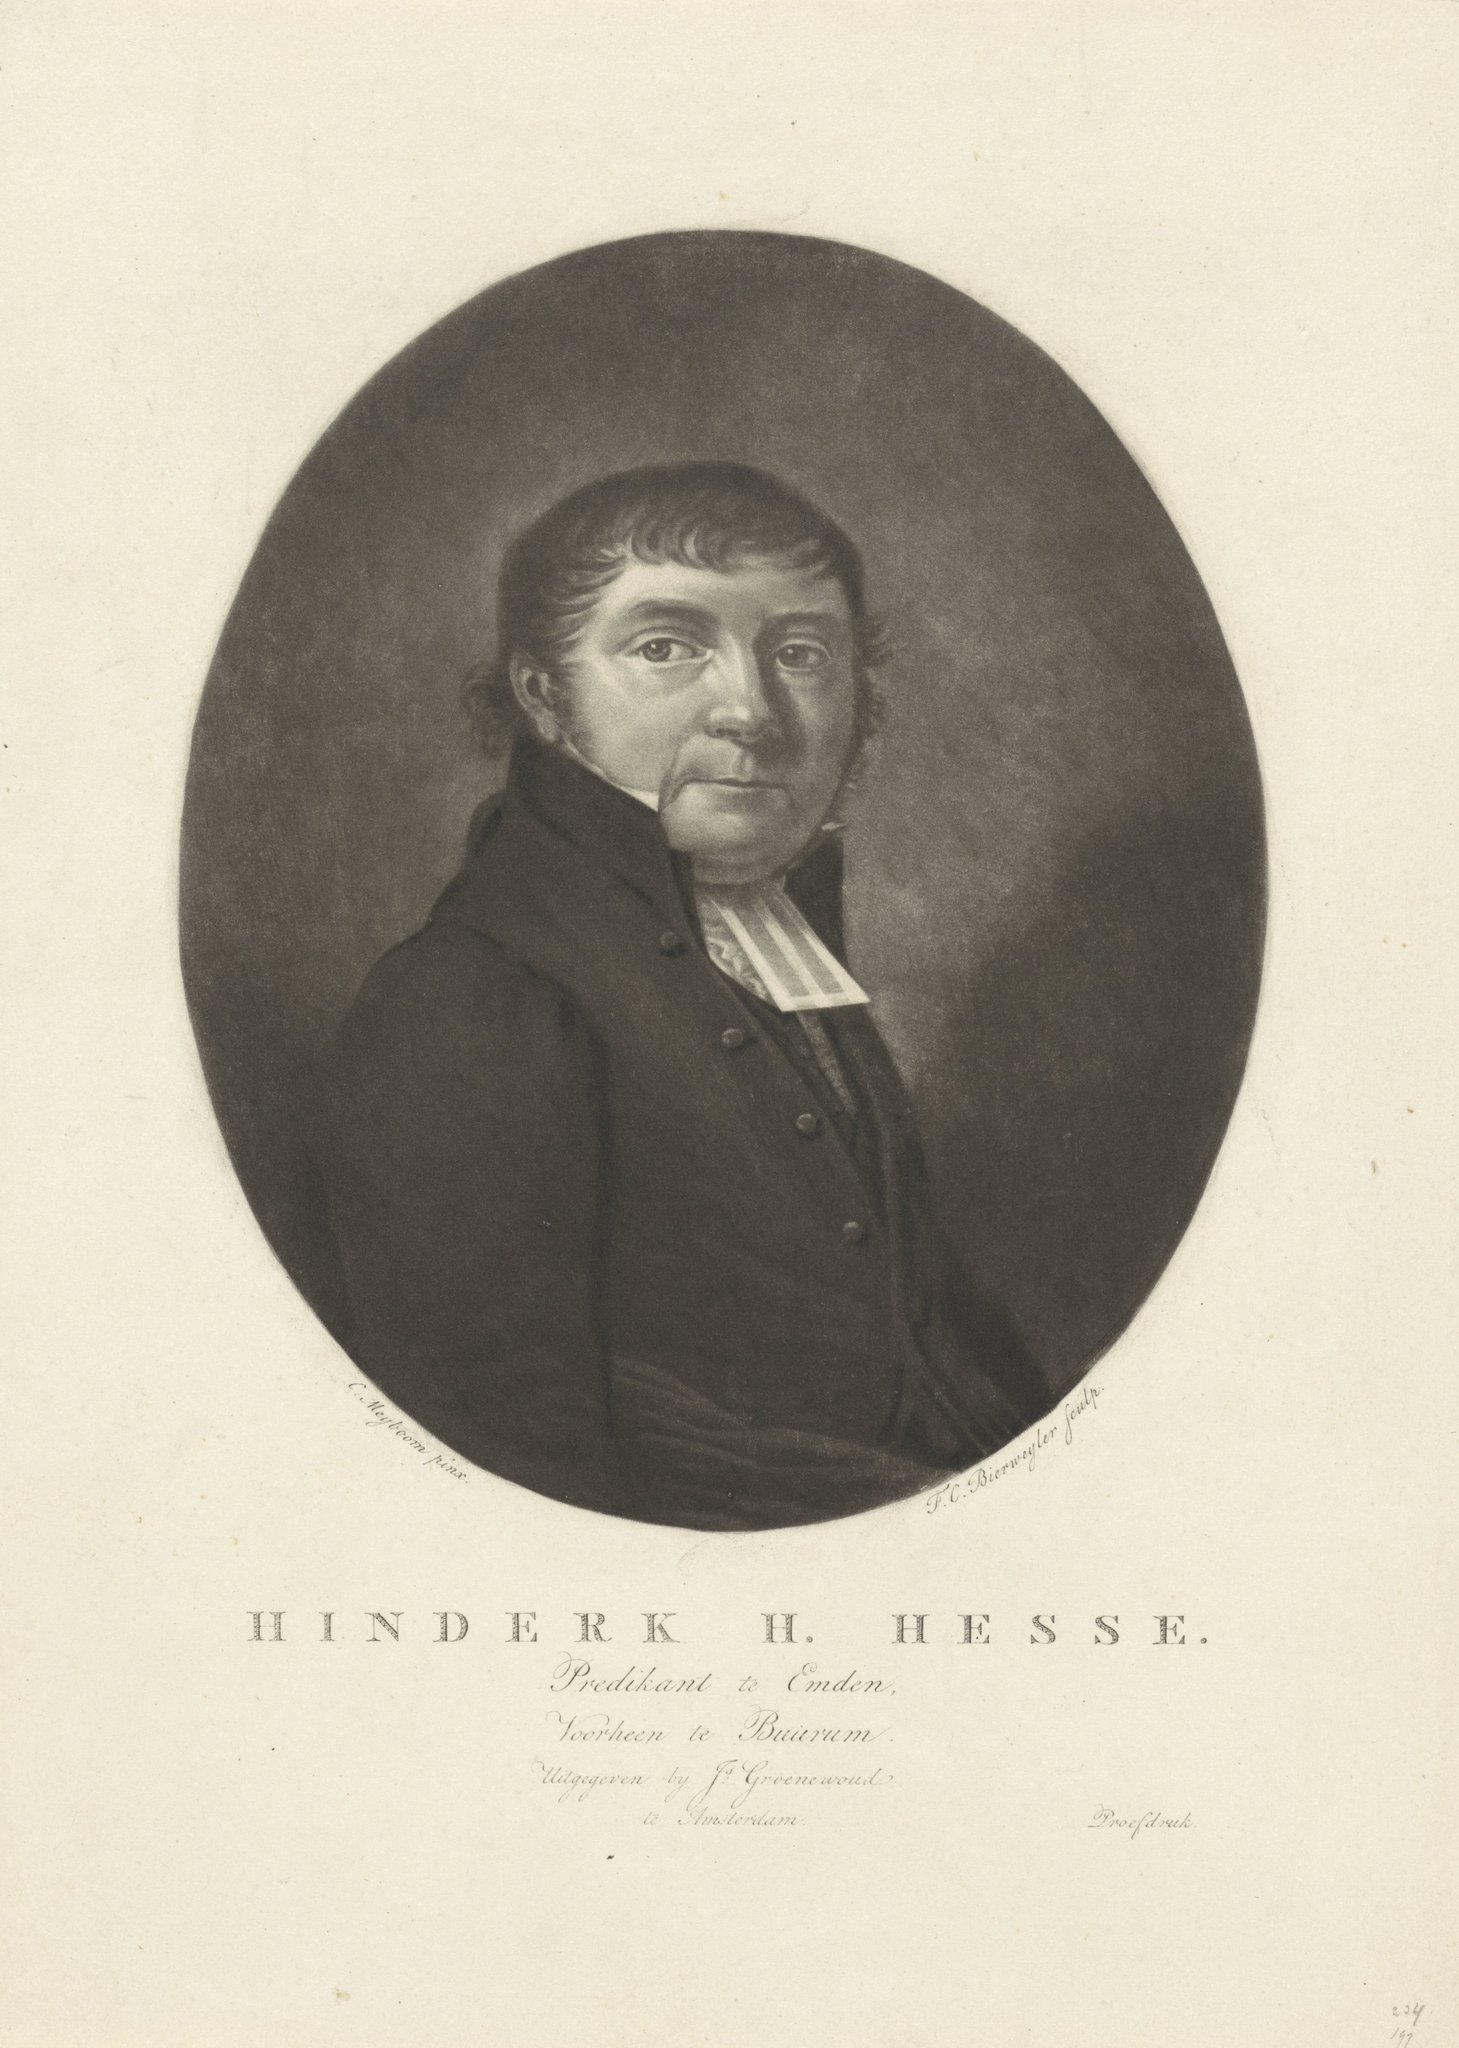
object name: print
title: Portret van de predikant Hinderk H. Hesse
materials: paper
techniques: engraving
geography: amsterdam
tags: hinderk h. hesse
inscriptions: collector's mark: Lugt 2228